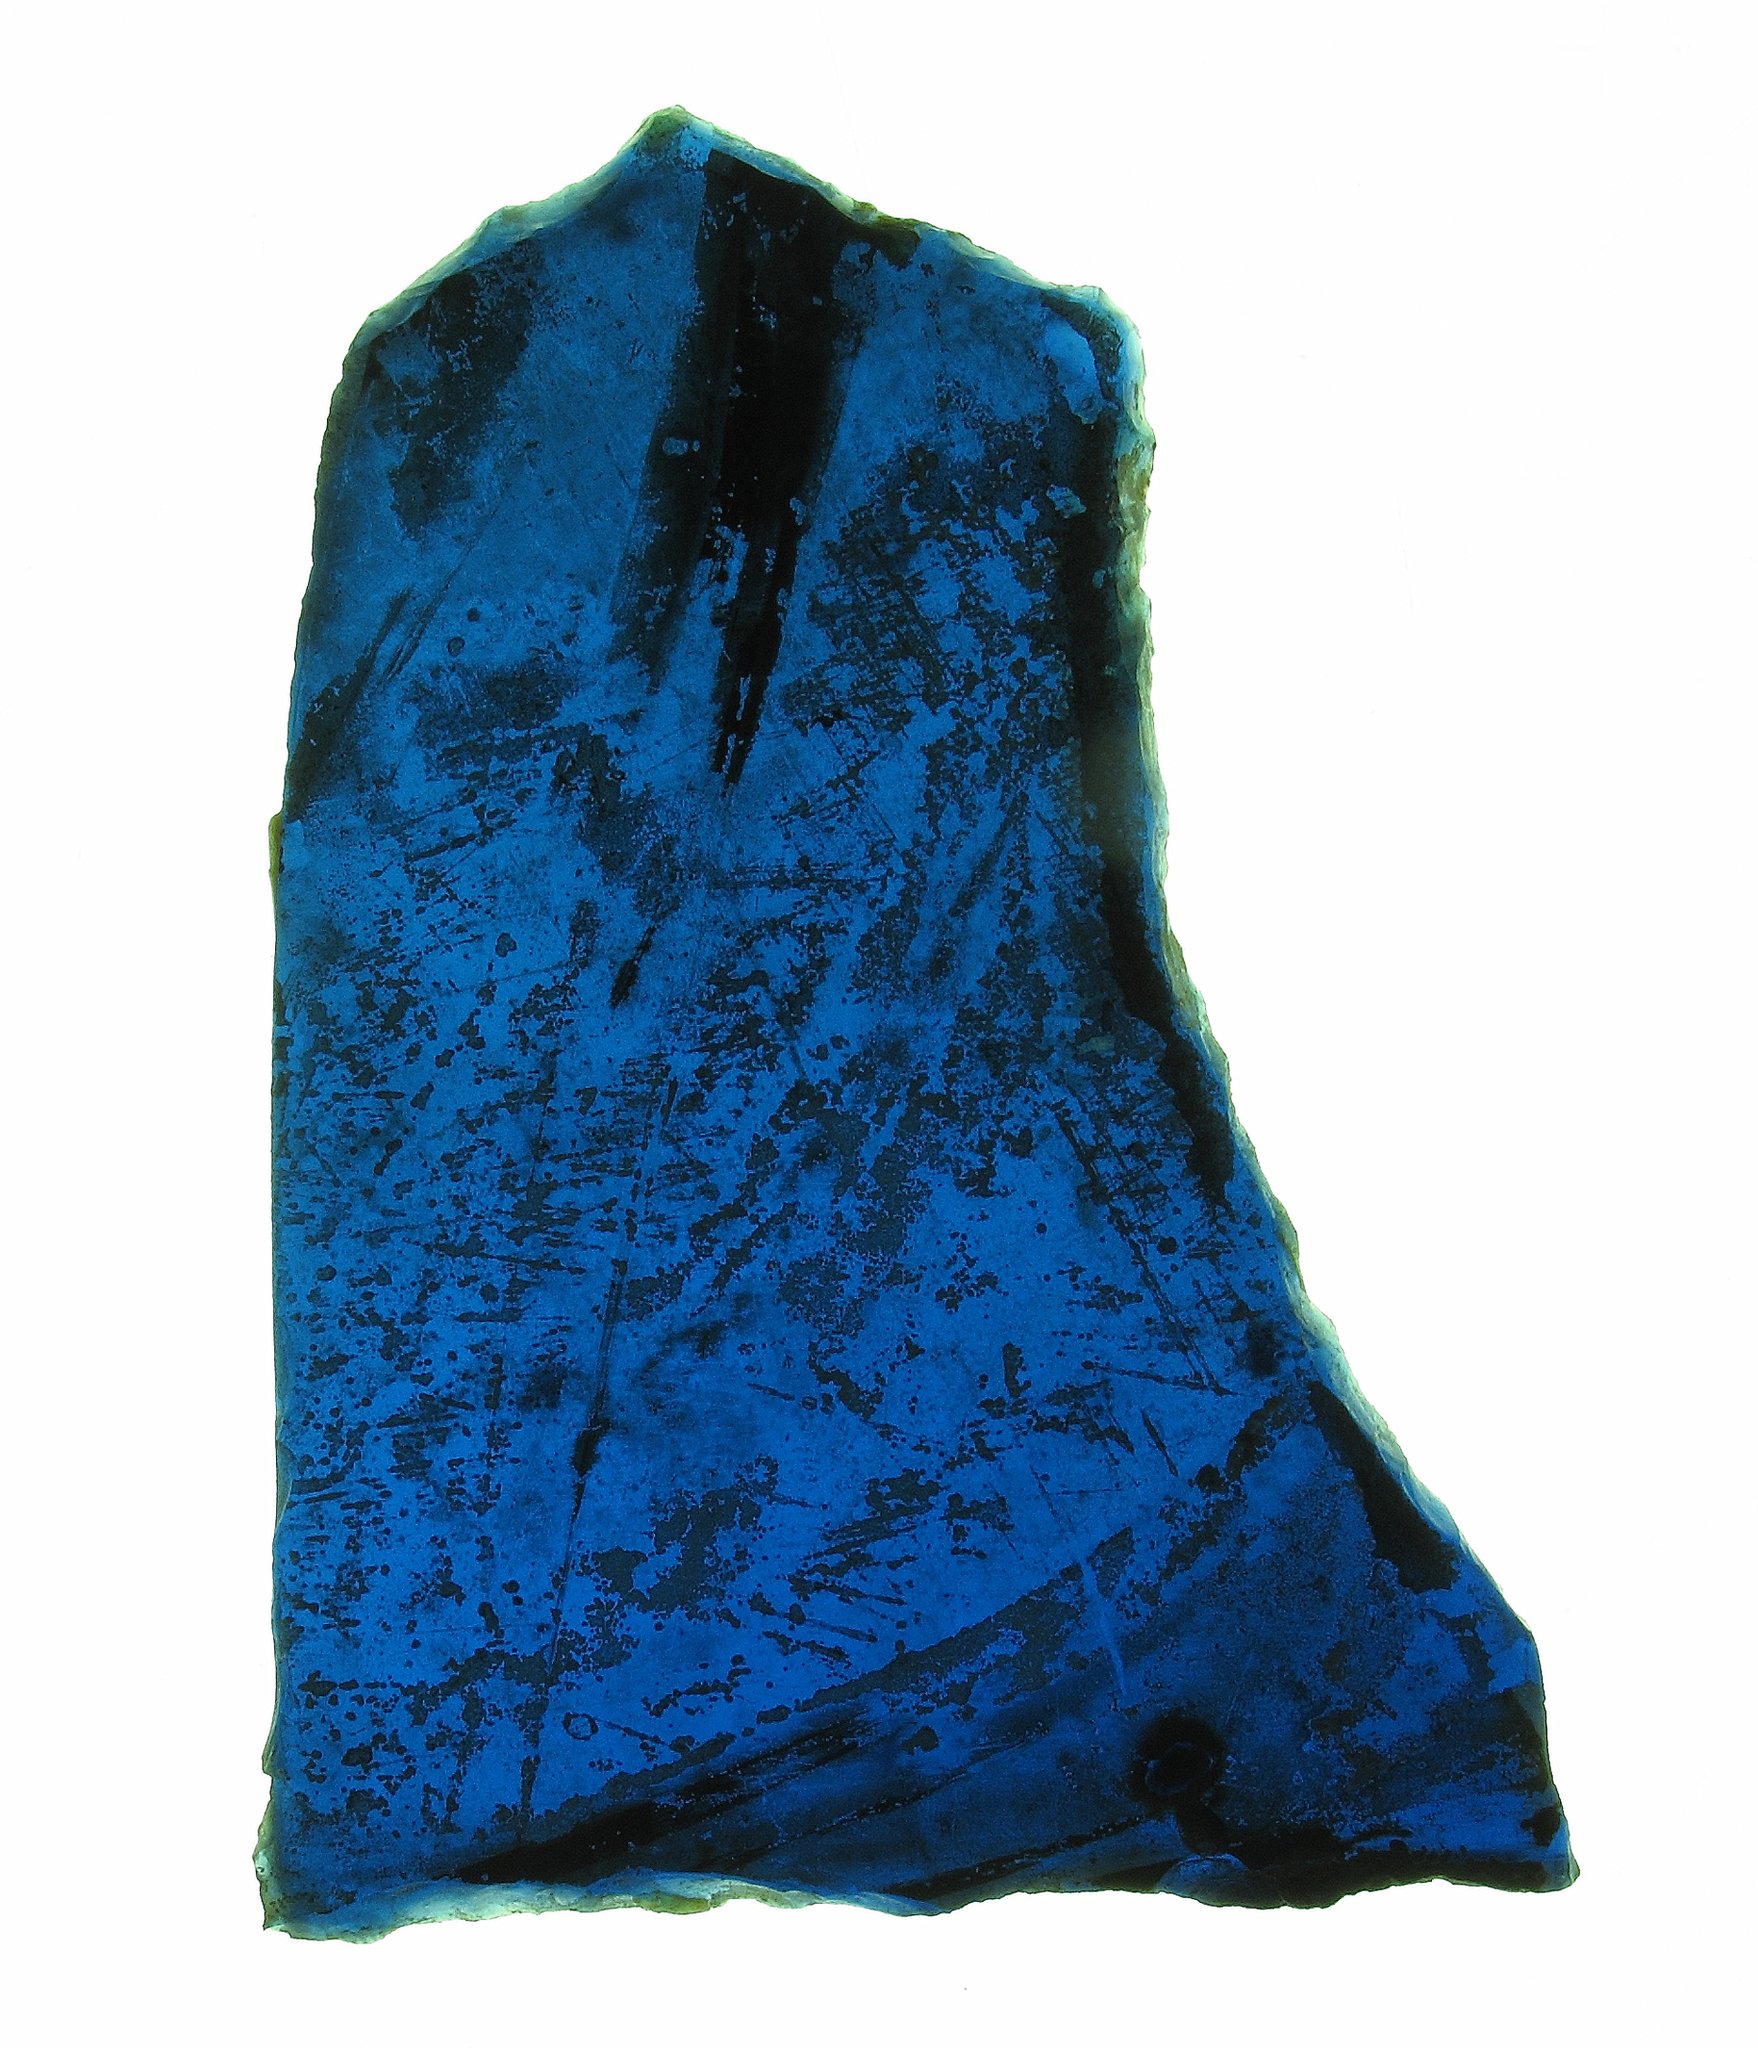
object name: fragment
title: Glass Fragment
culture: european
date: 1301-1500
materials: glass, metal